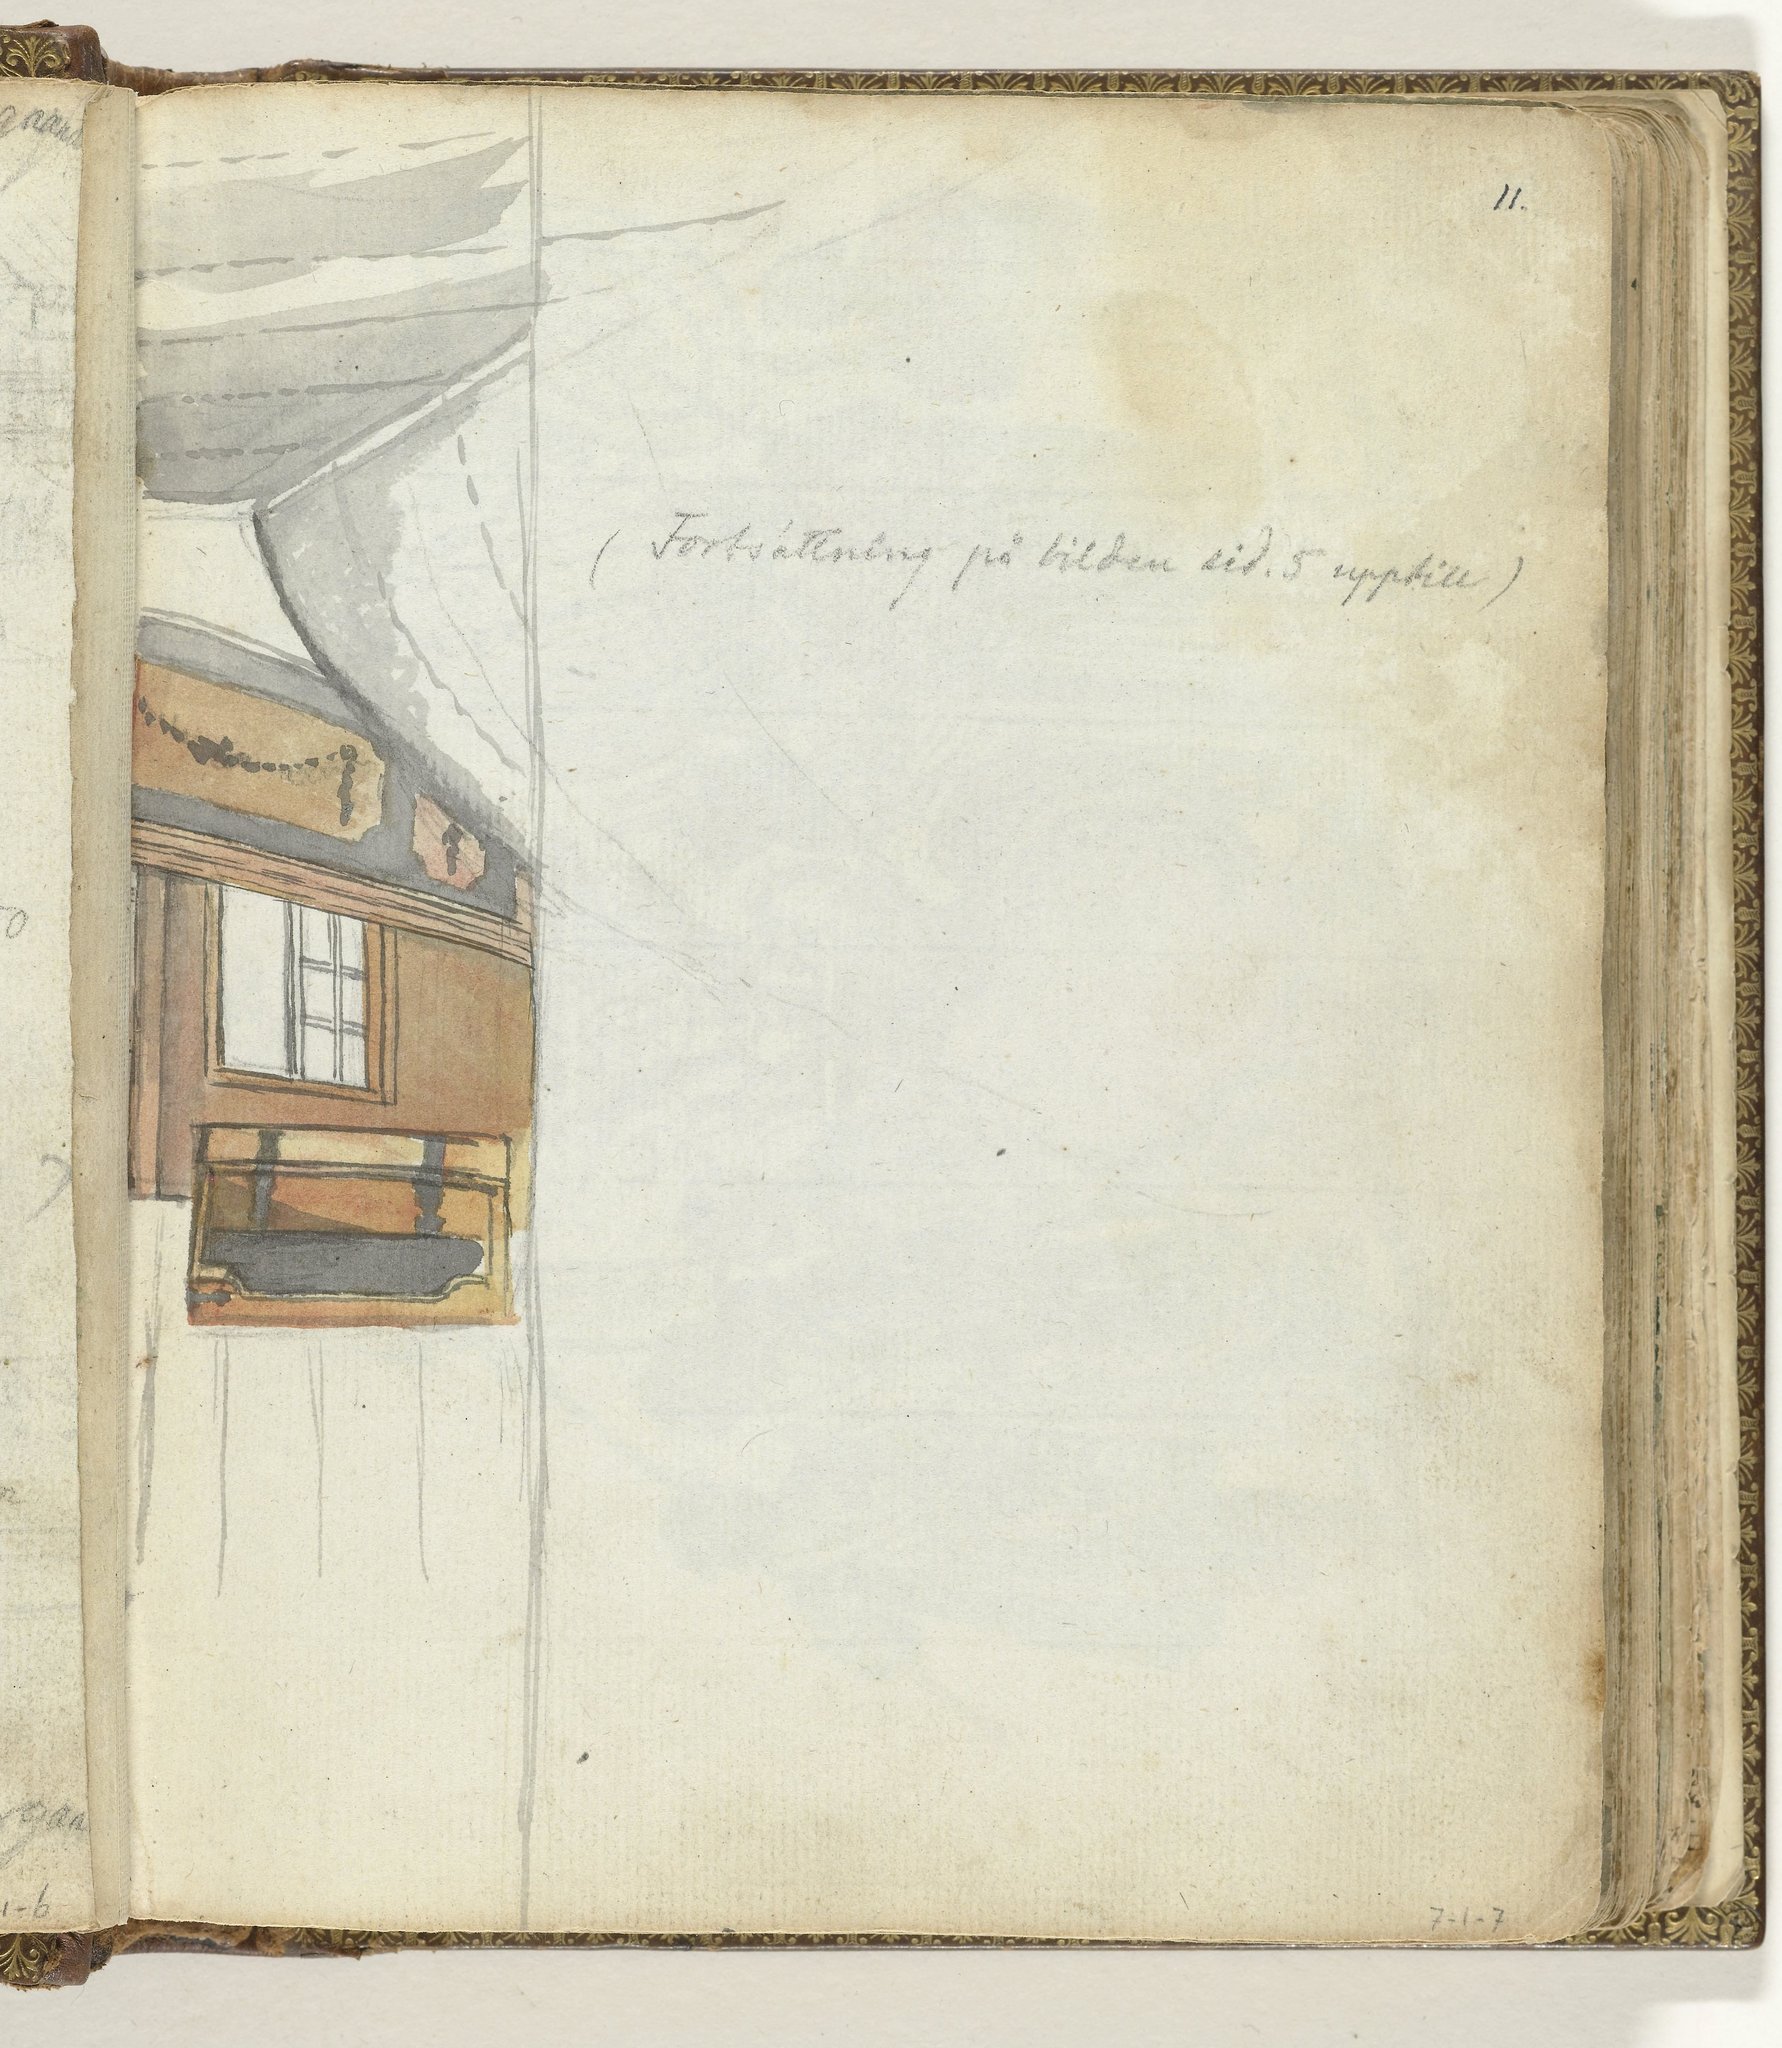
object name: drawing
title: Deel van het scheepsdek van een VOC-schip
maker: jan brandes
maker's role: draughtsman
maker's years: 1743-1808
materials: paper, pencil, watercolor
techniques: brush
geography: batavia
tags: parts of ship's exterior: deck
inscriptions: inscription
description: Deze tekening hoort ter rechterzijde van NG-1985-7-1-3. Zichtbaar zijn een stuk van het halfdek, een kist, een raam van de officiersverblijven en een stuk van de zeilen. Het 20e eeuwse bijschrift is Zweeds en verwijst naar bovennoemd nummer. Onderdeel uit het schetsboek van Jan Brandes, dl. 1 (1808), p. 11.